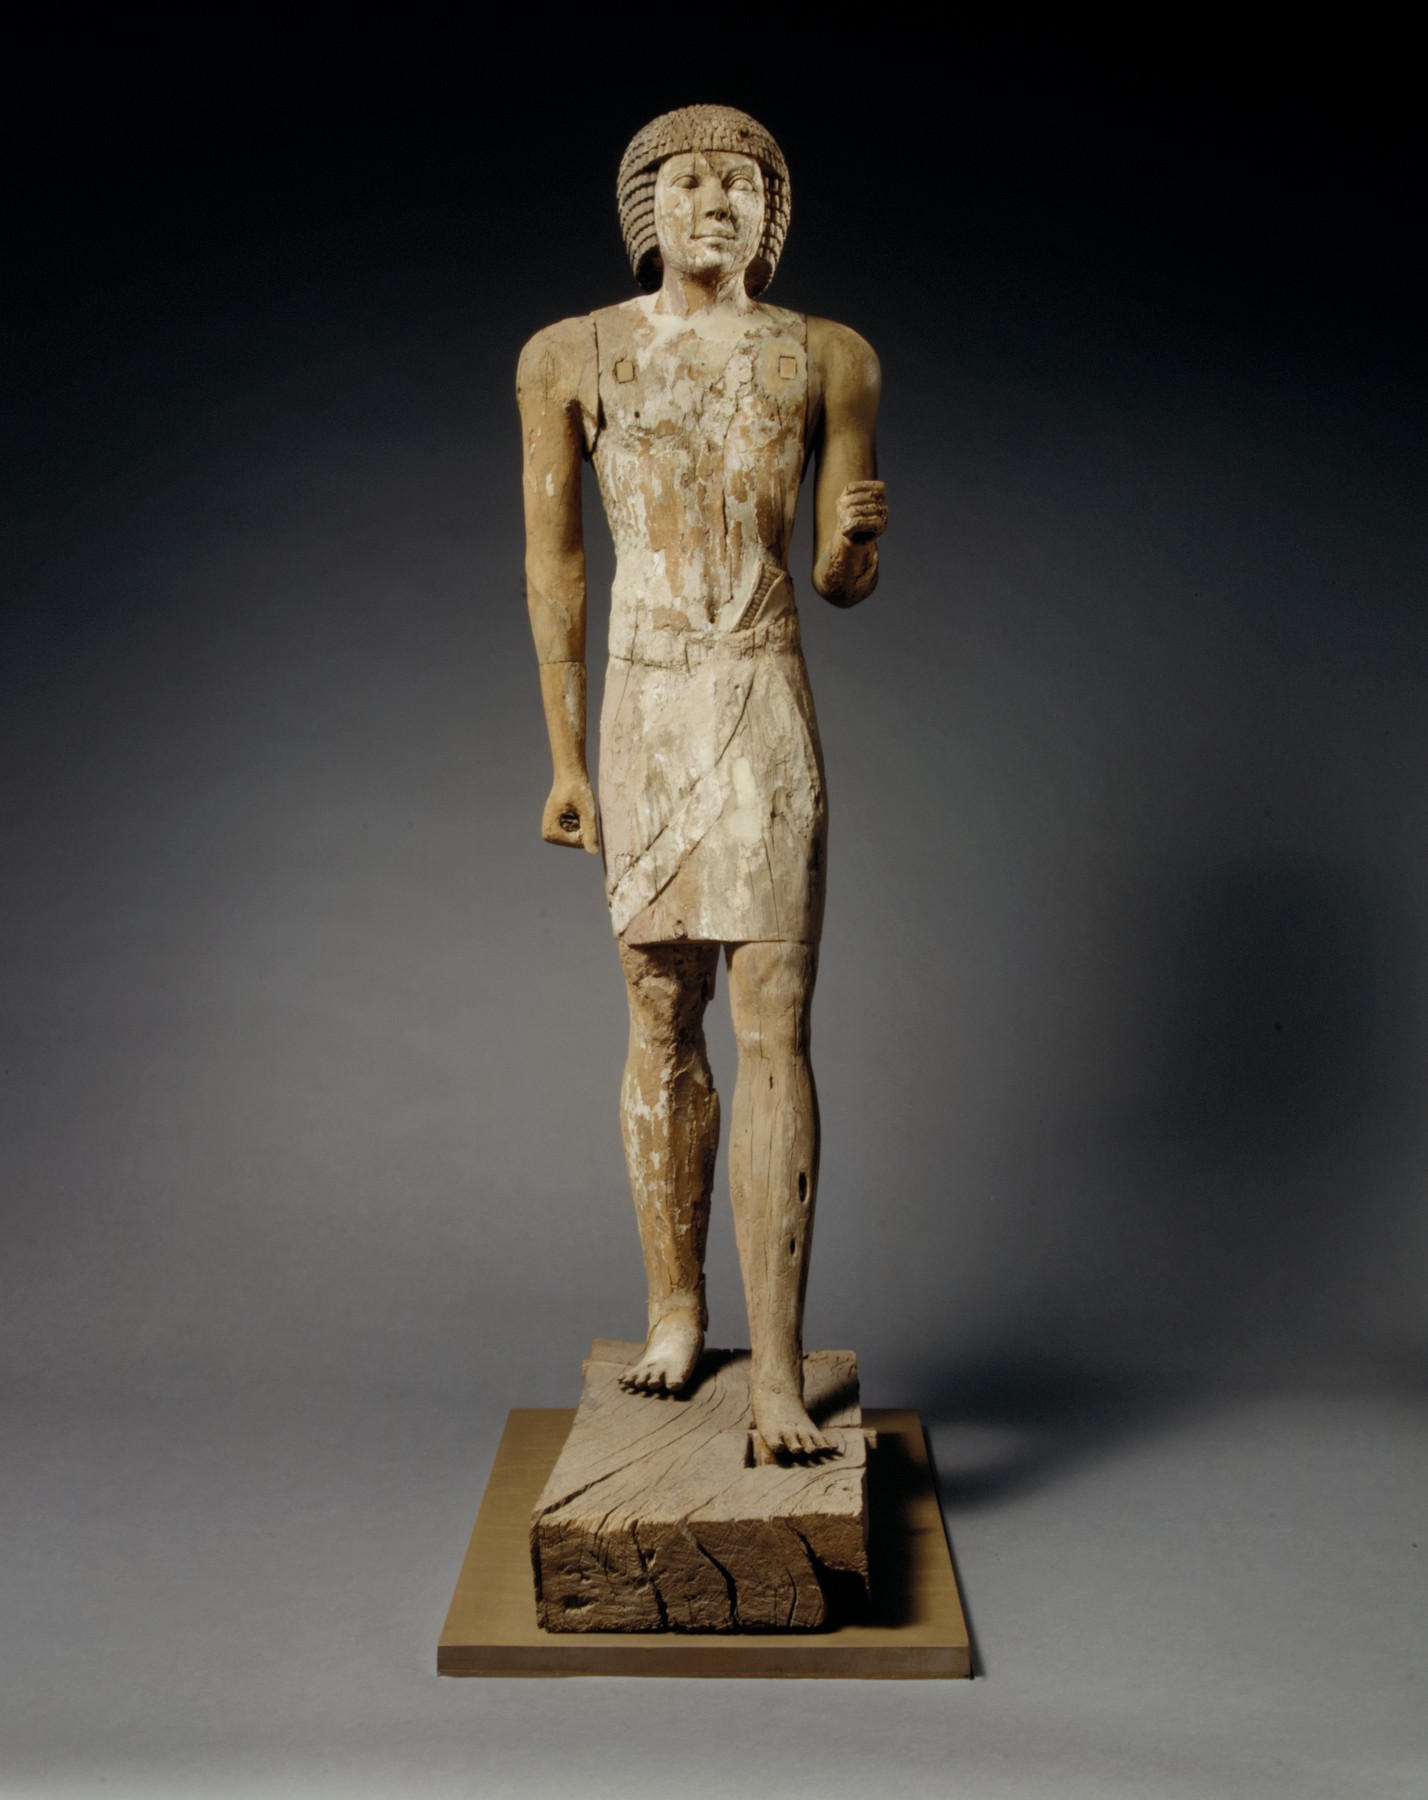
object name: statue, kaemsenu standing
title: Standing statue of Kaemsenu (?)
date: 2420-2389 BCE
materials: gesso, paint, wood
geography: egypt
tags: men